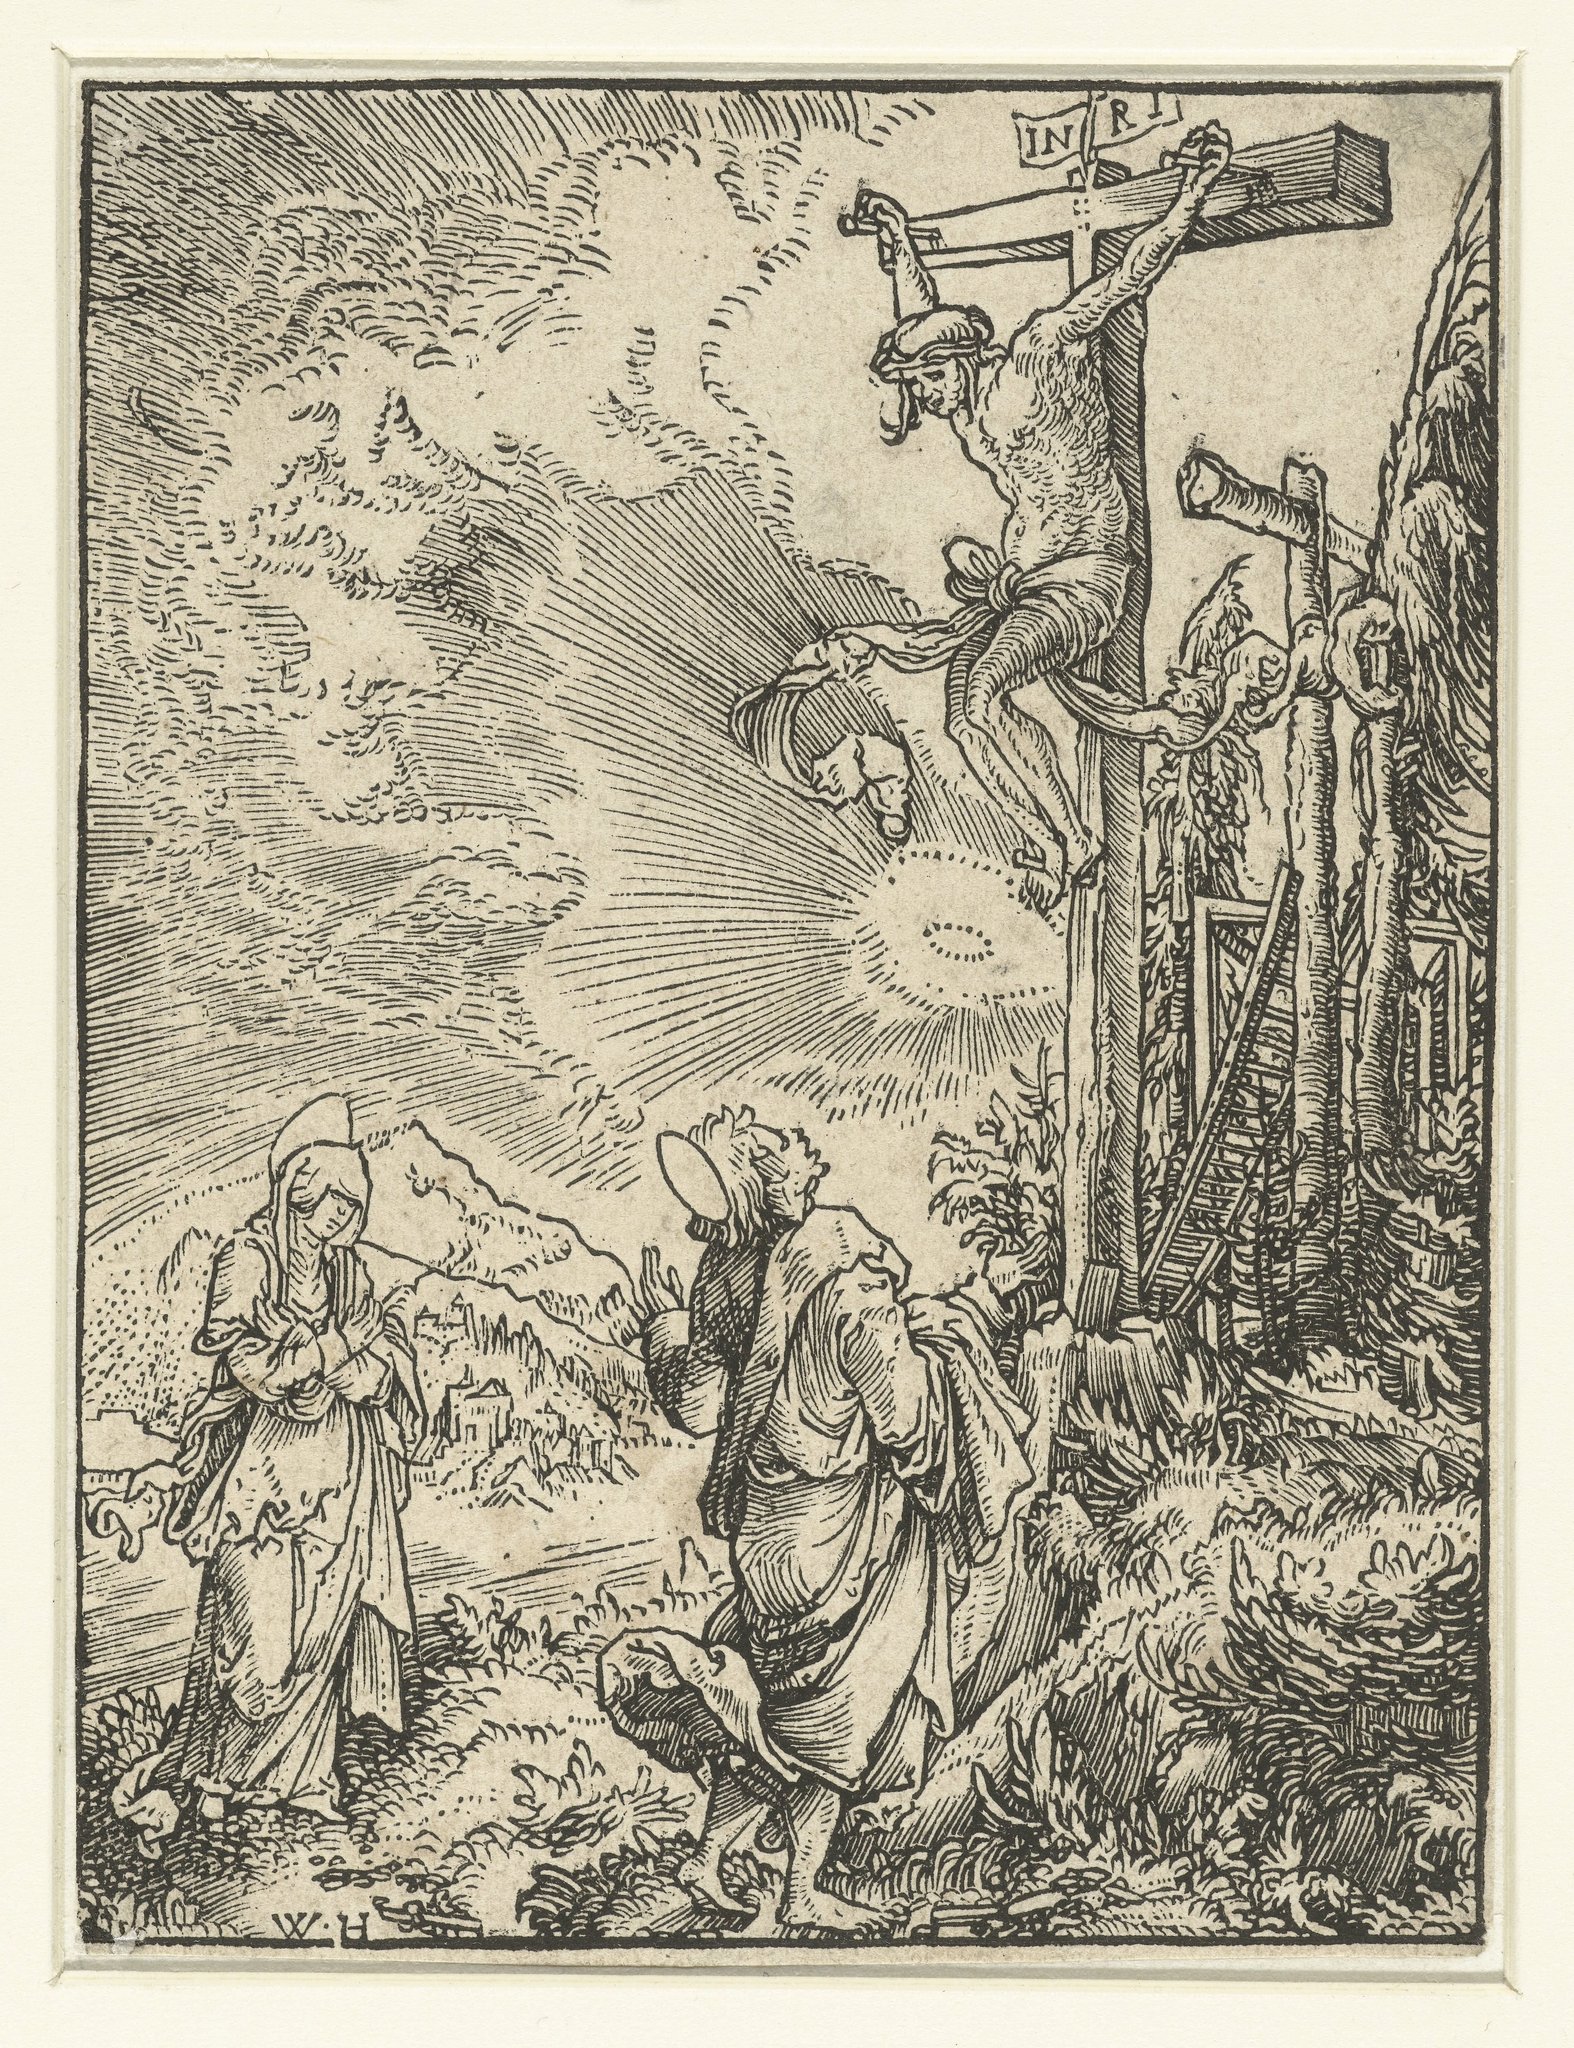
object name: print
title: Christus aan het kruis met Maria en Johannes de Evangelist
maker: wolfgang huber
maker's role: draughtsman, print maker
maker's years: 1490-1553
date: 1500-1553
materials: paper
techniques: woodcut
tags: crucified christ with mary and john on either side of the cross; holy rood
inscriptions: collector's mark: Lugt 240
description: Maria en Johannes de Evangelist staan onder het kruis van Christus op de berg Golgotha. Maria heeft haar handen gevouwen in gebed en Johannes heft zijn handen in een wanhopig gebaar. Christus is met opvallend grote spijkers aan het kruis genageld.